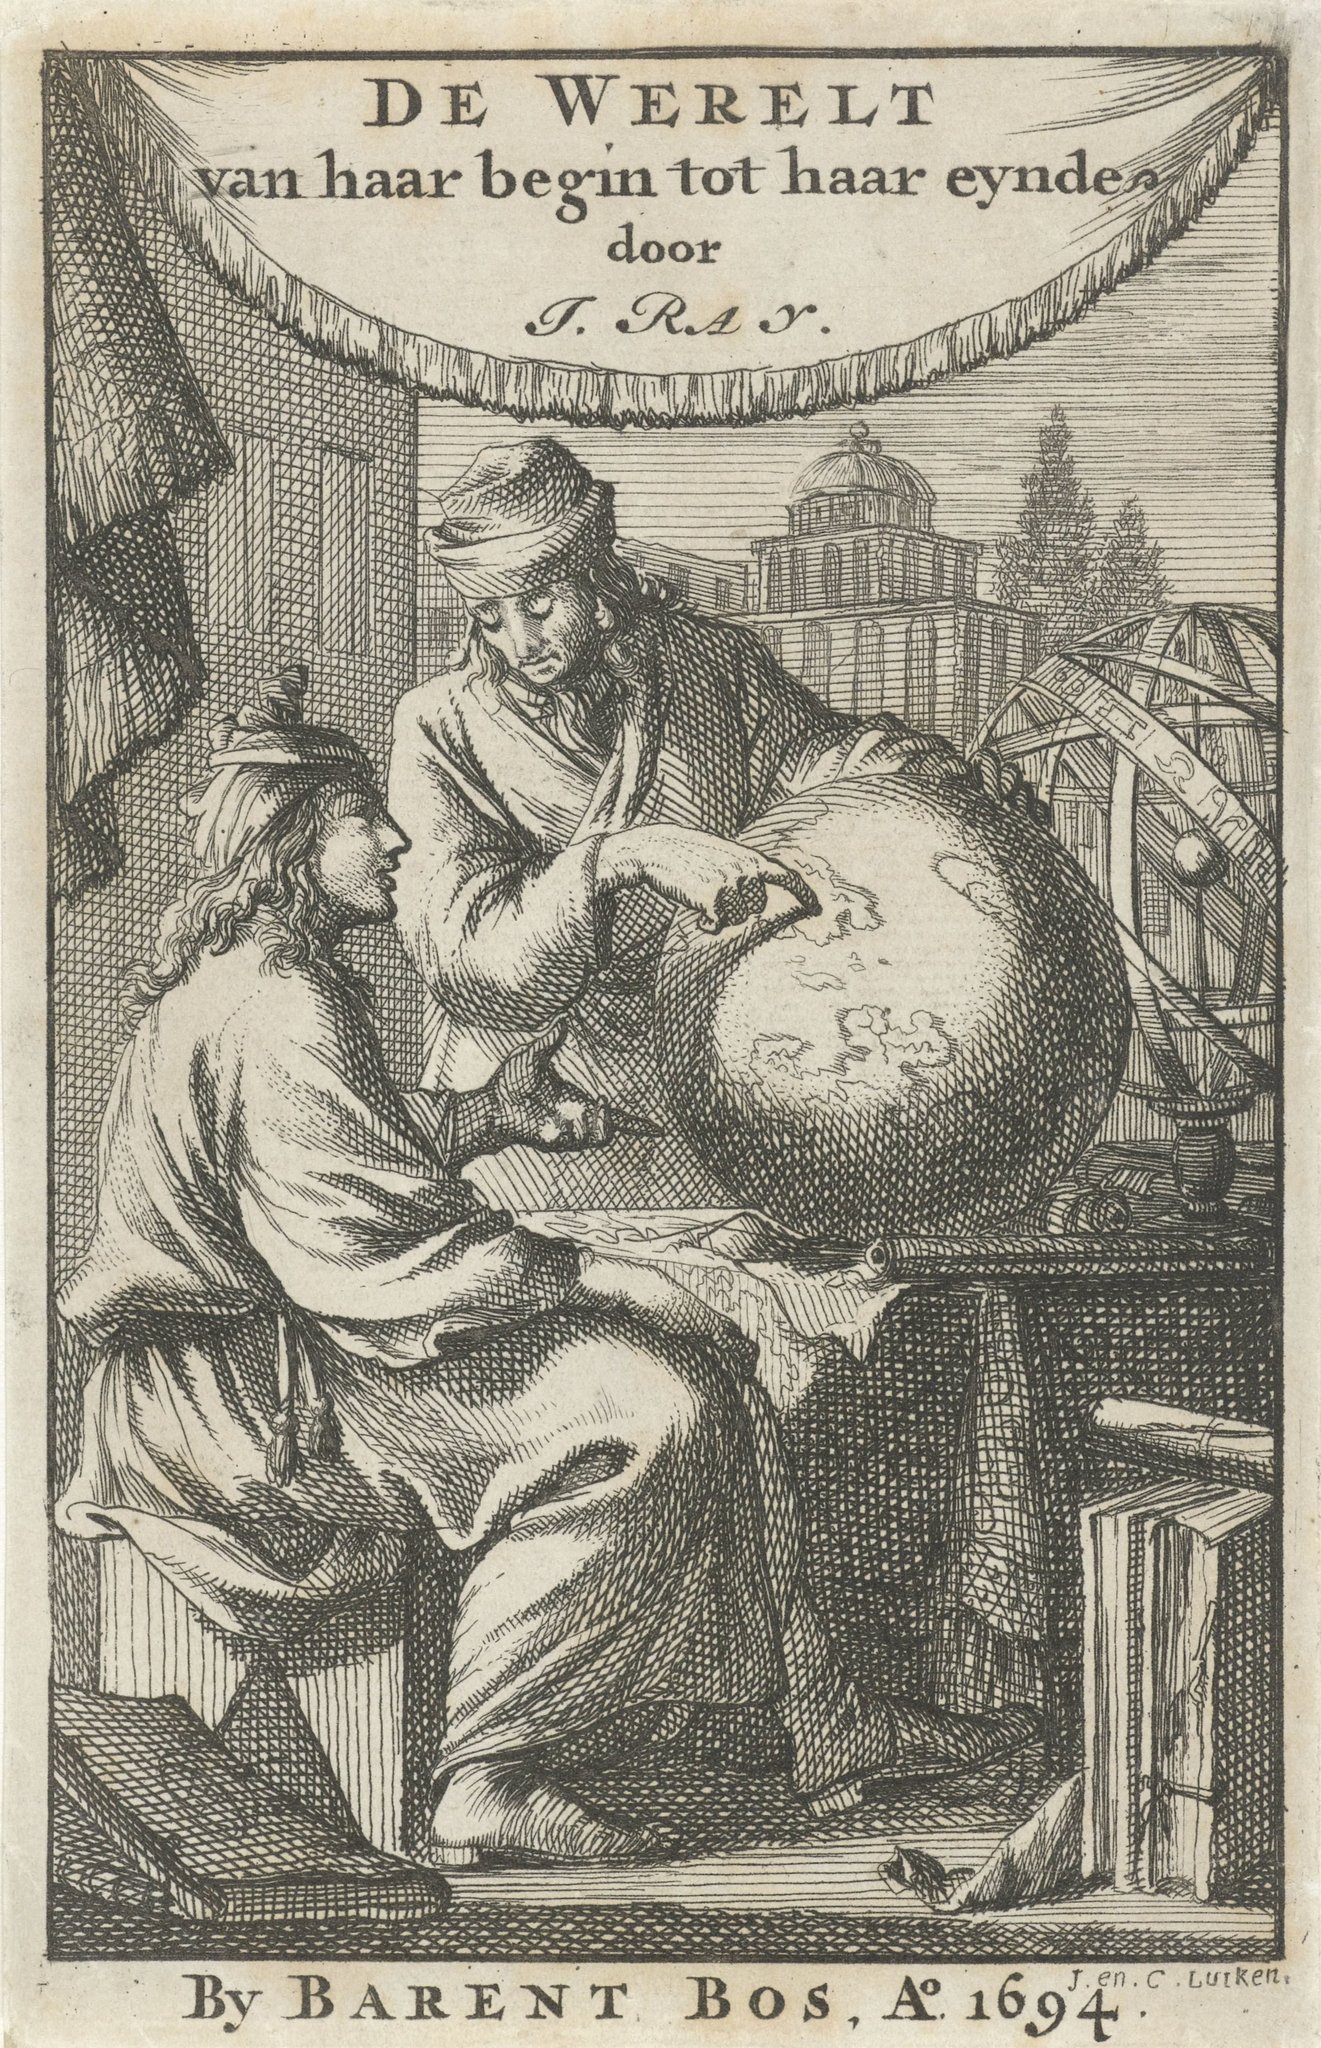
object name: print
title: Titelpagina voor: J. Ray, De werelt van haar begin tot haar einde, 1694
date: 1694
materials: paper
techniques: etching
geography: amsterdam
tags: globe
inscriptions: collector's mark: Lugt 2228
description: Titelpagina voor: Ray, John. De werelt van haar begin tot haar einde. Rotterdam: Barent Bos, 1694.